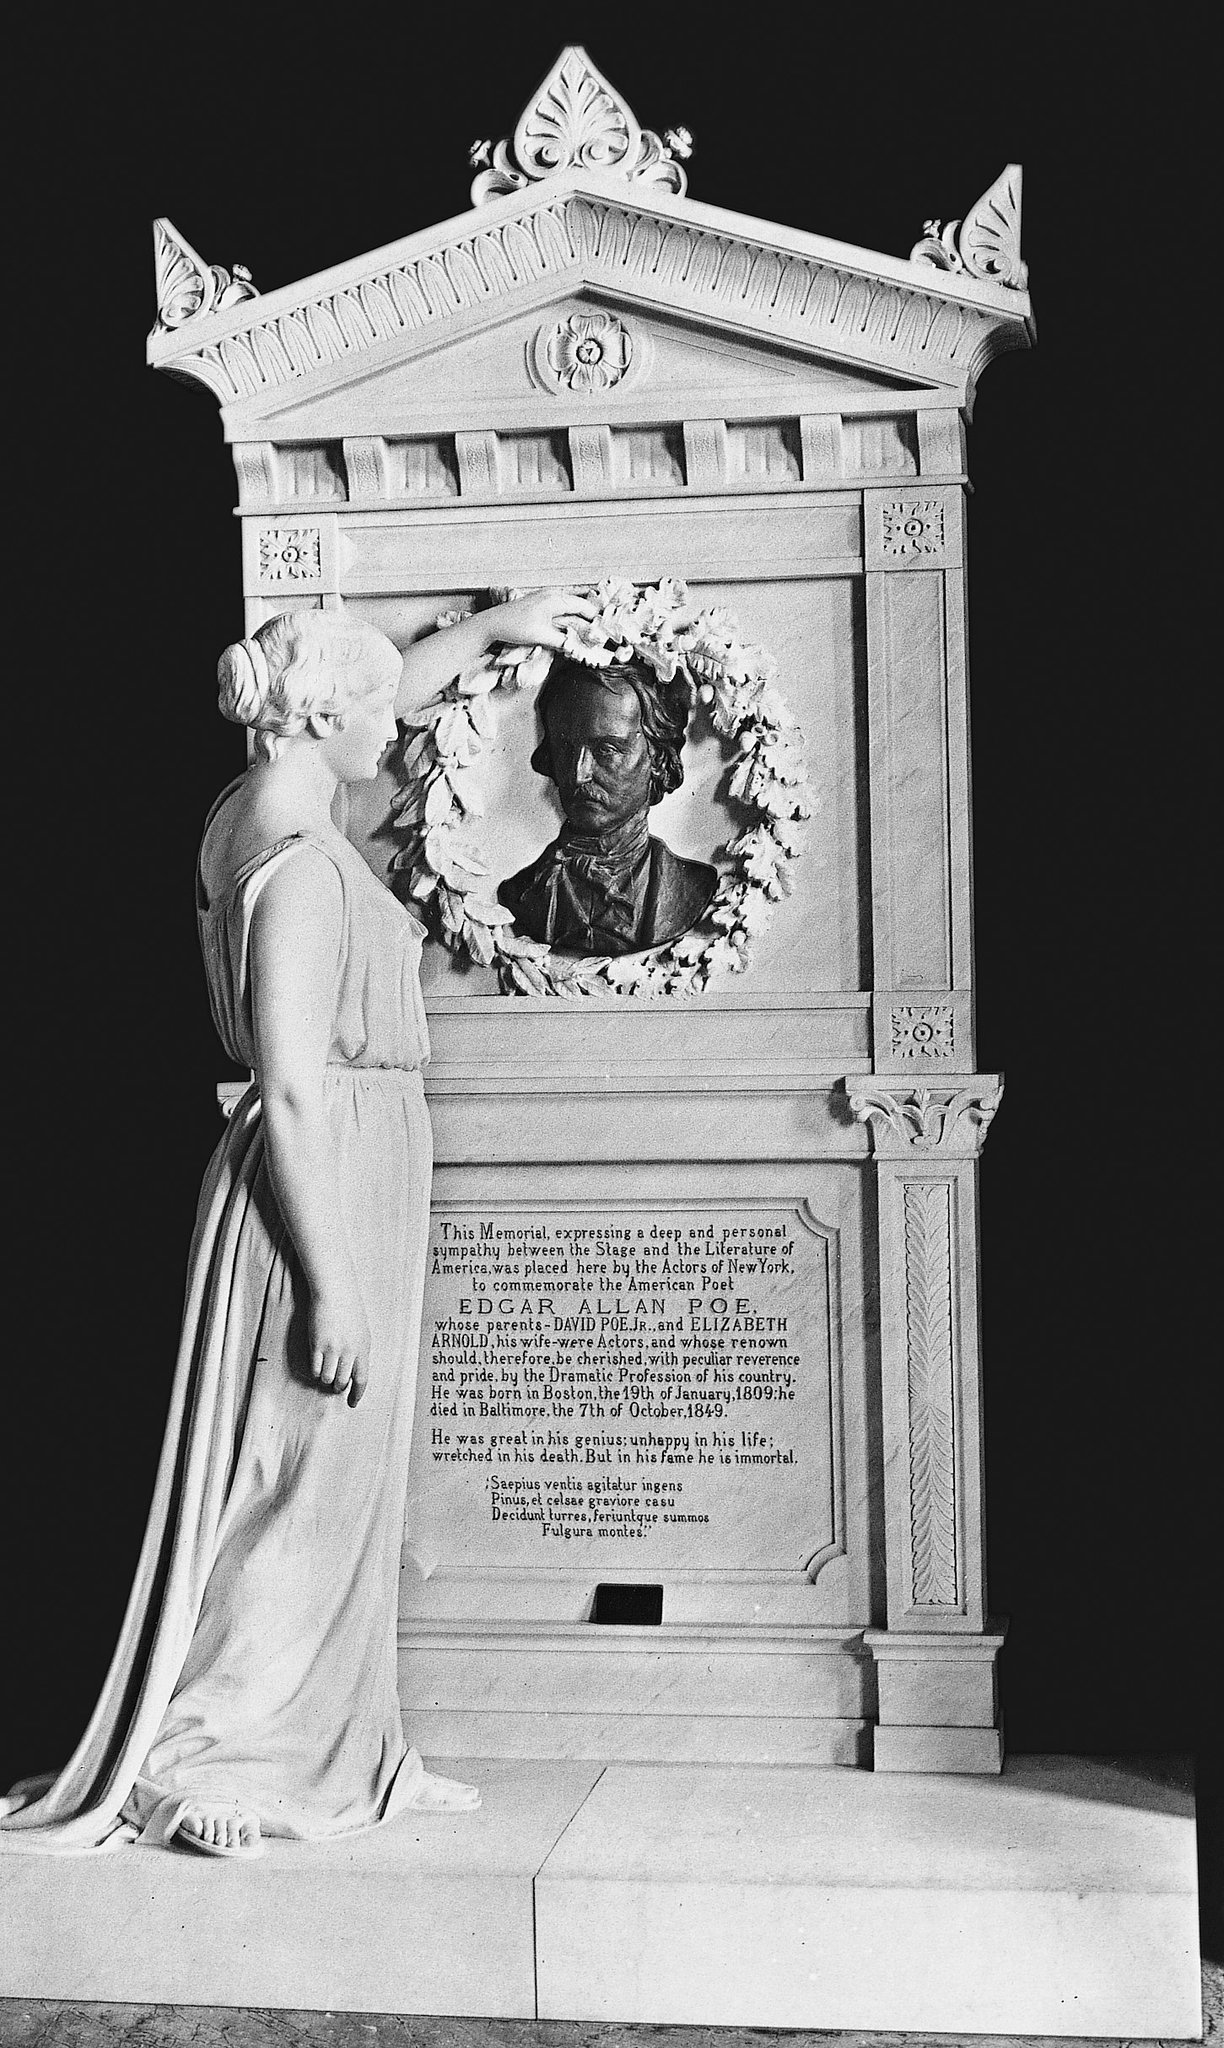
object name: sculpture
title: Edgar Allan Poe Memorial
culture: american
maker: richard henry park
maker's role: artist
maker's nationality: american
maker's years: 1832-1902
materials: bronze, marble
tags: garlands,men,portraits,women